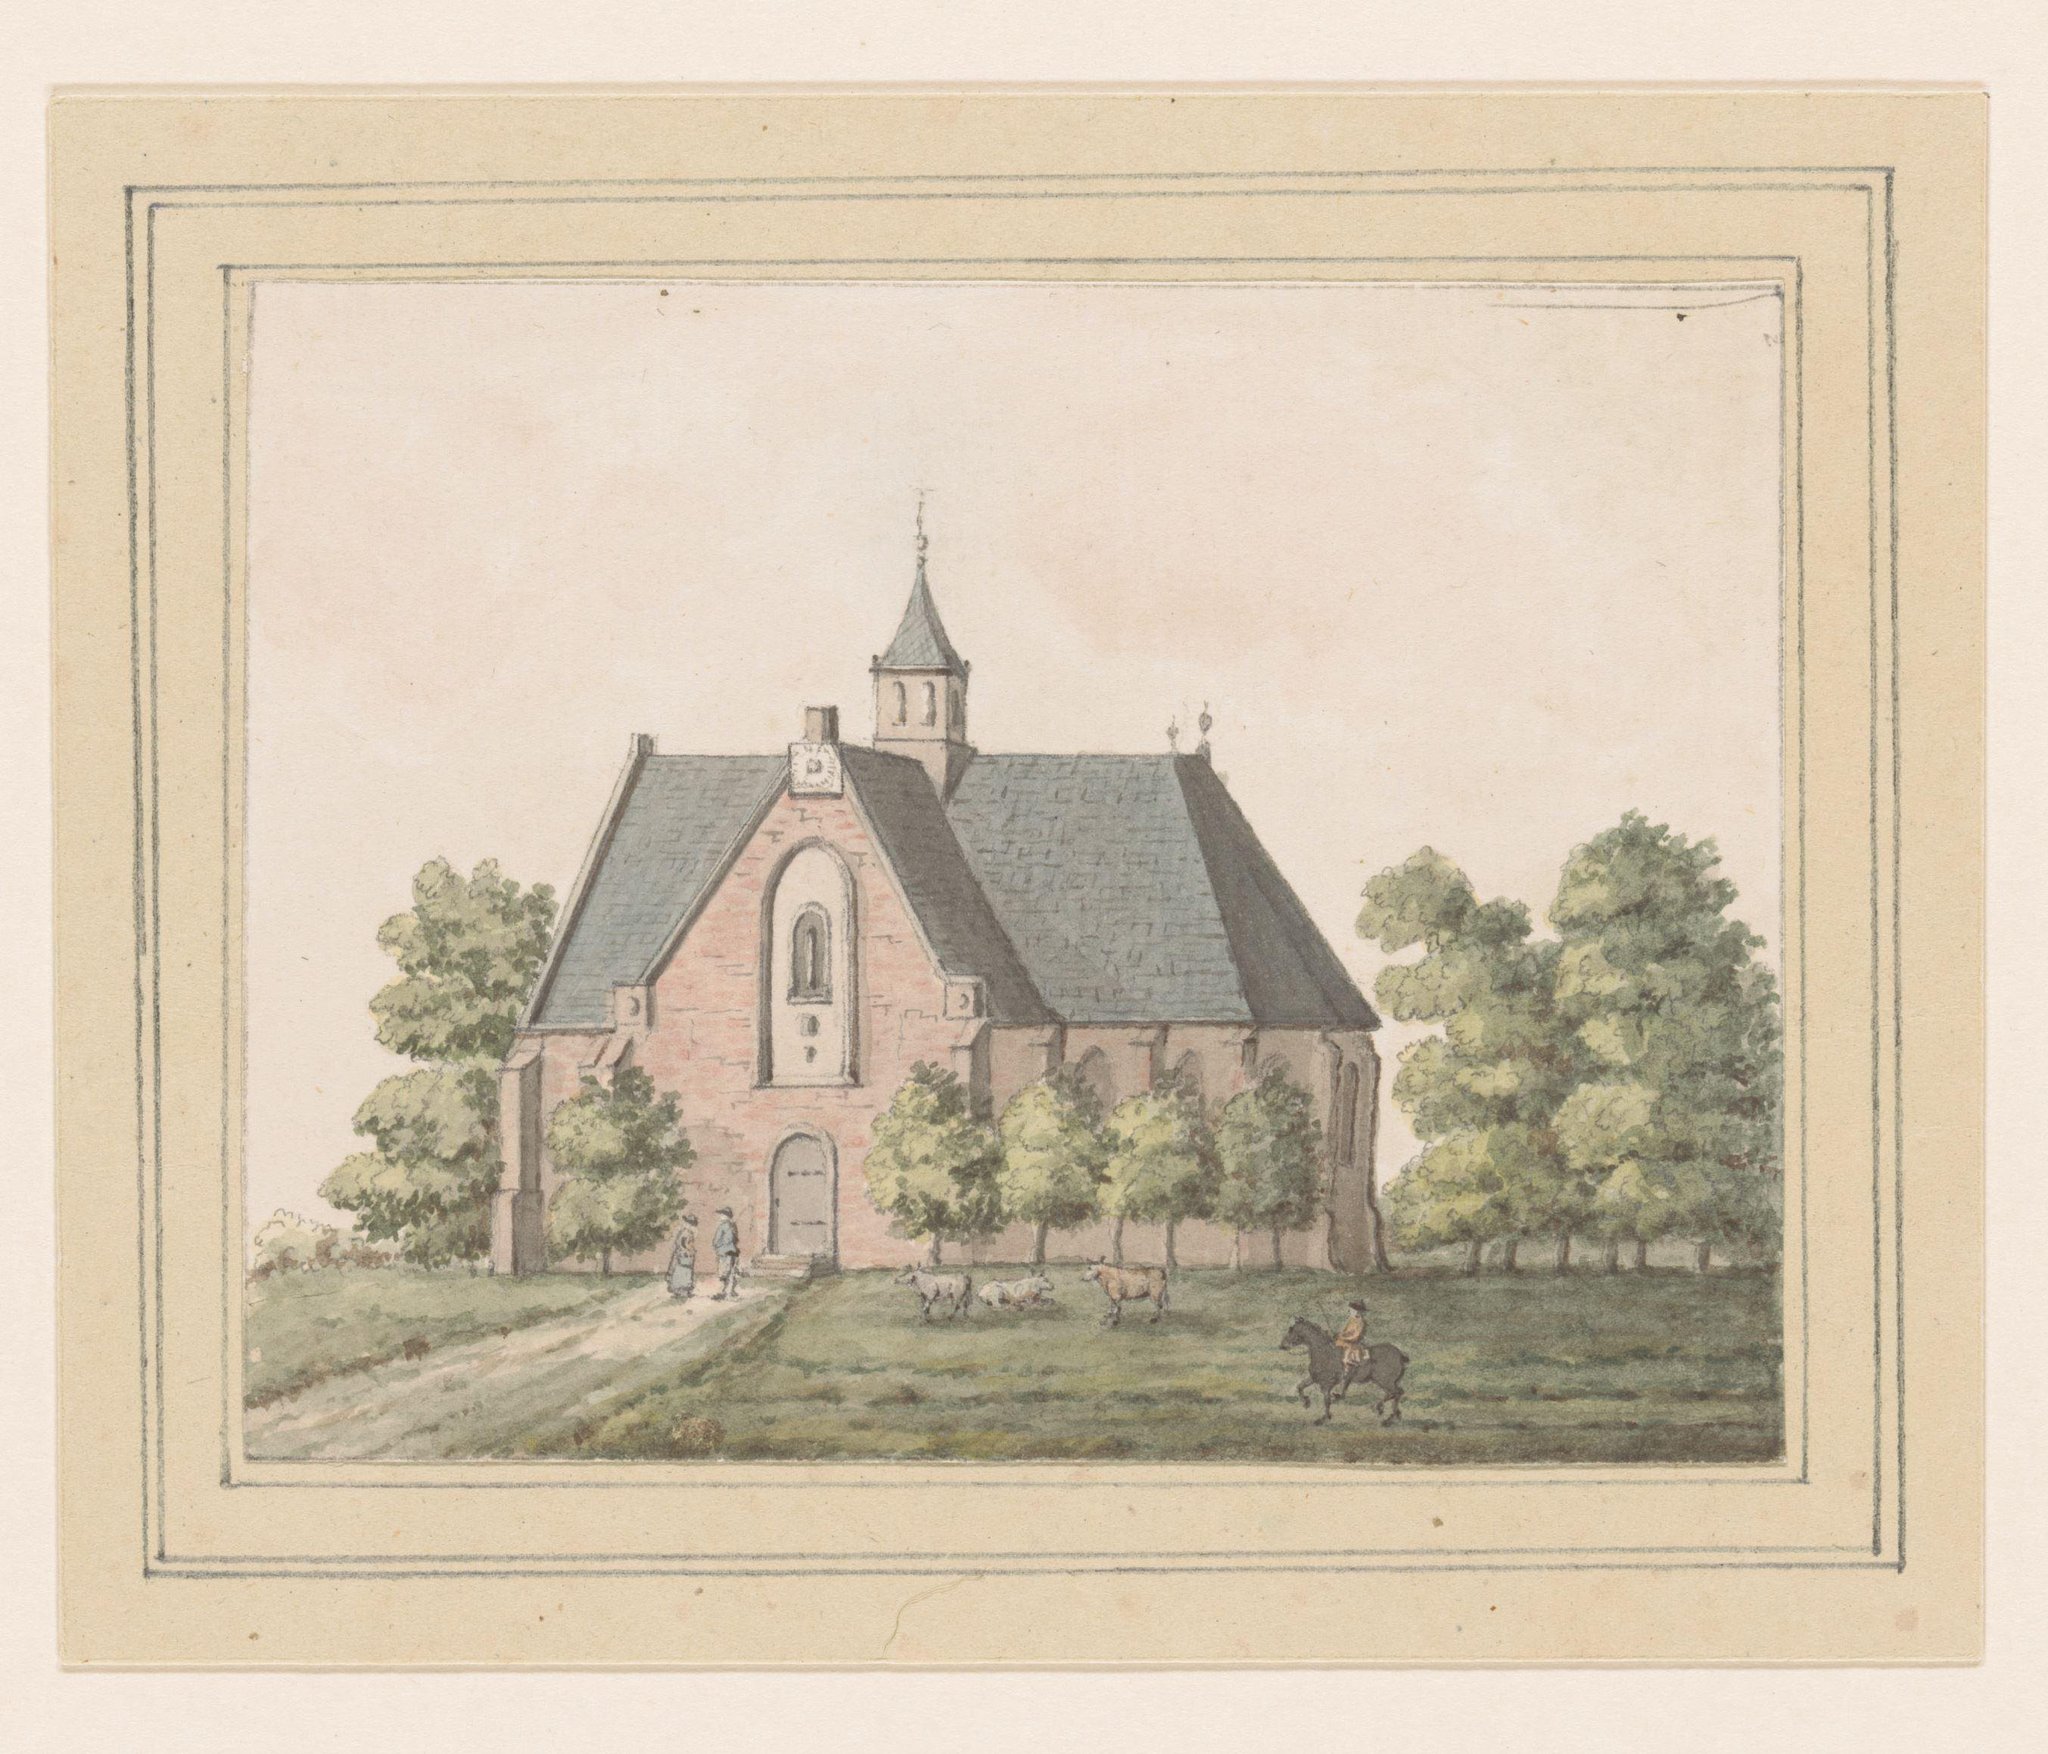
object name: drawing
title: Gezicht op de kerk te Sint Pancras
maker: Anonymous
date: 1700-1800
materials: ink, paper, watercolor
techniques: brush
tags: roman catholic church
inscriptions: inscription: ‘Kerk van St. Pancras’